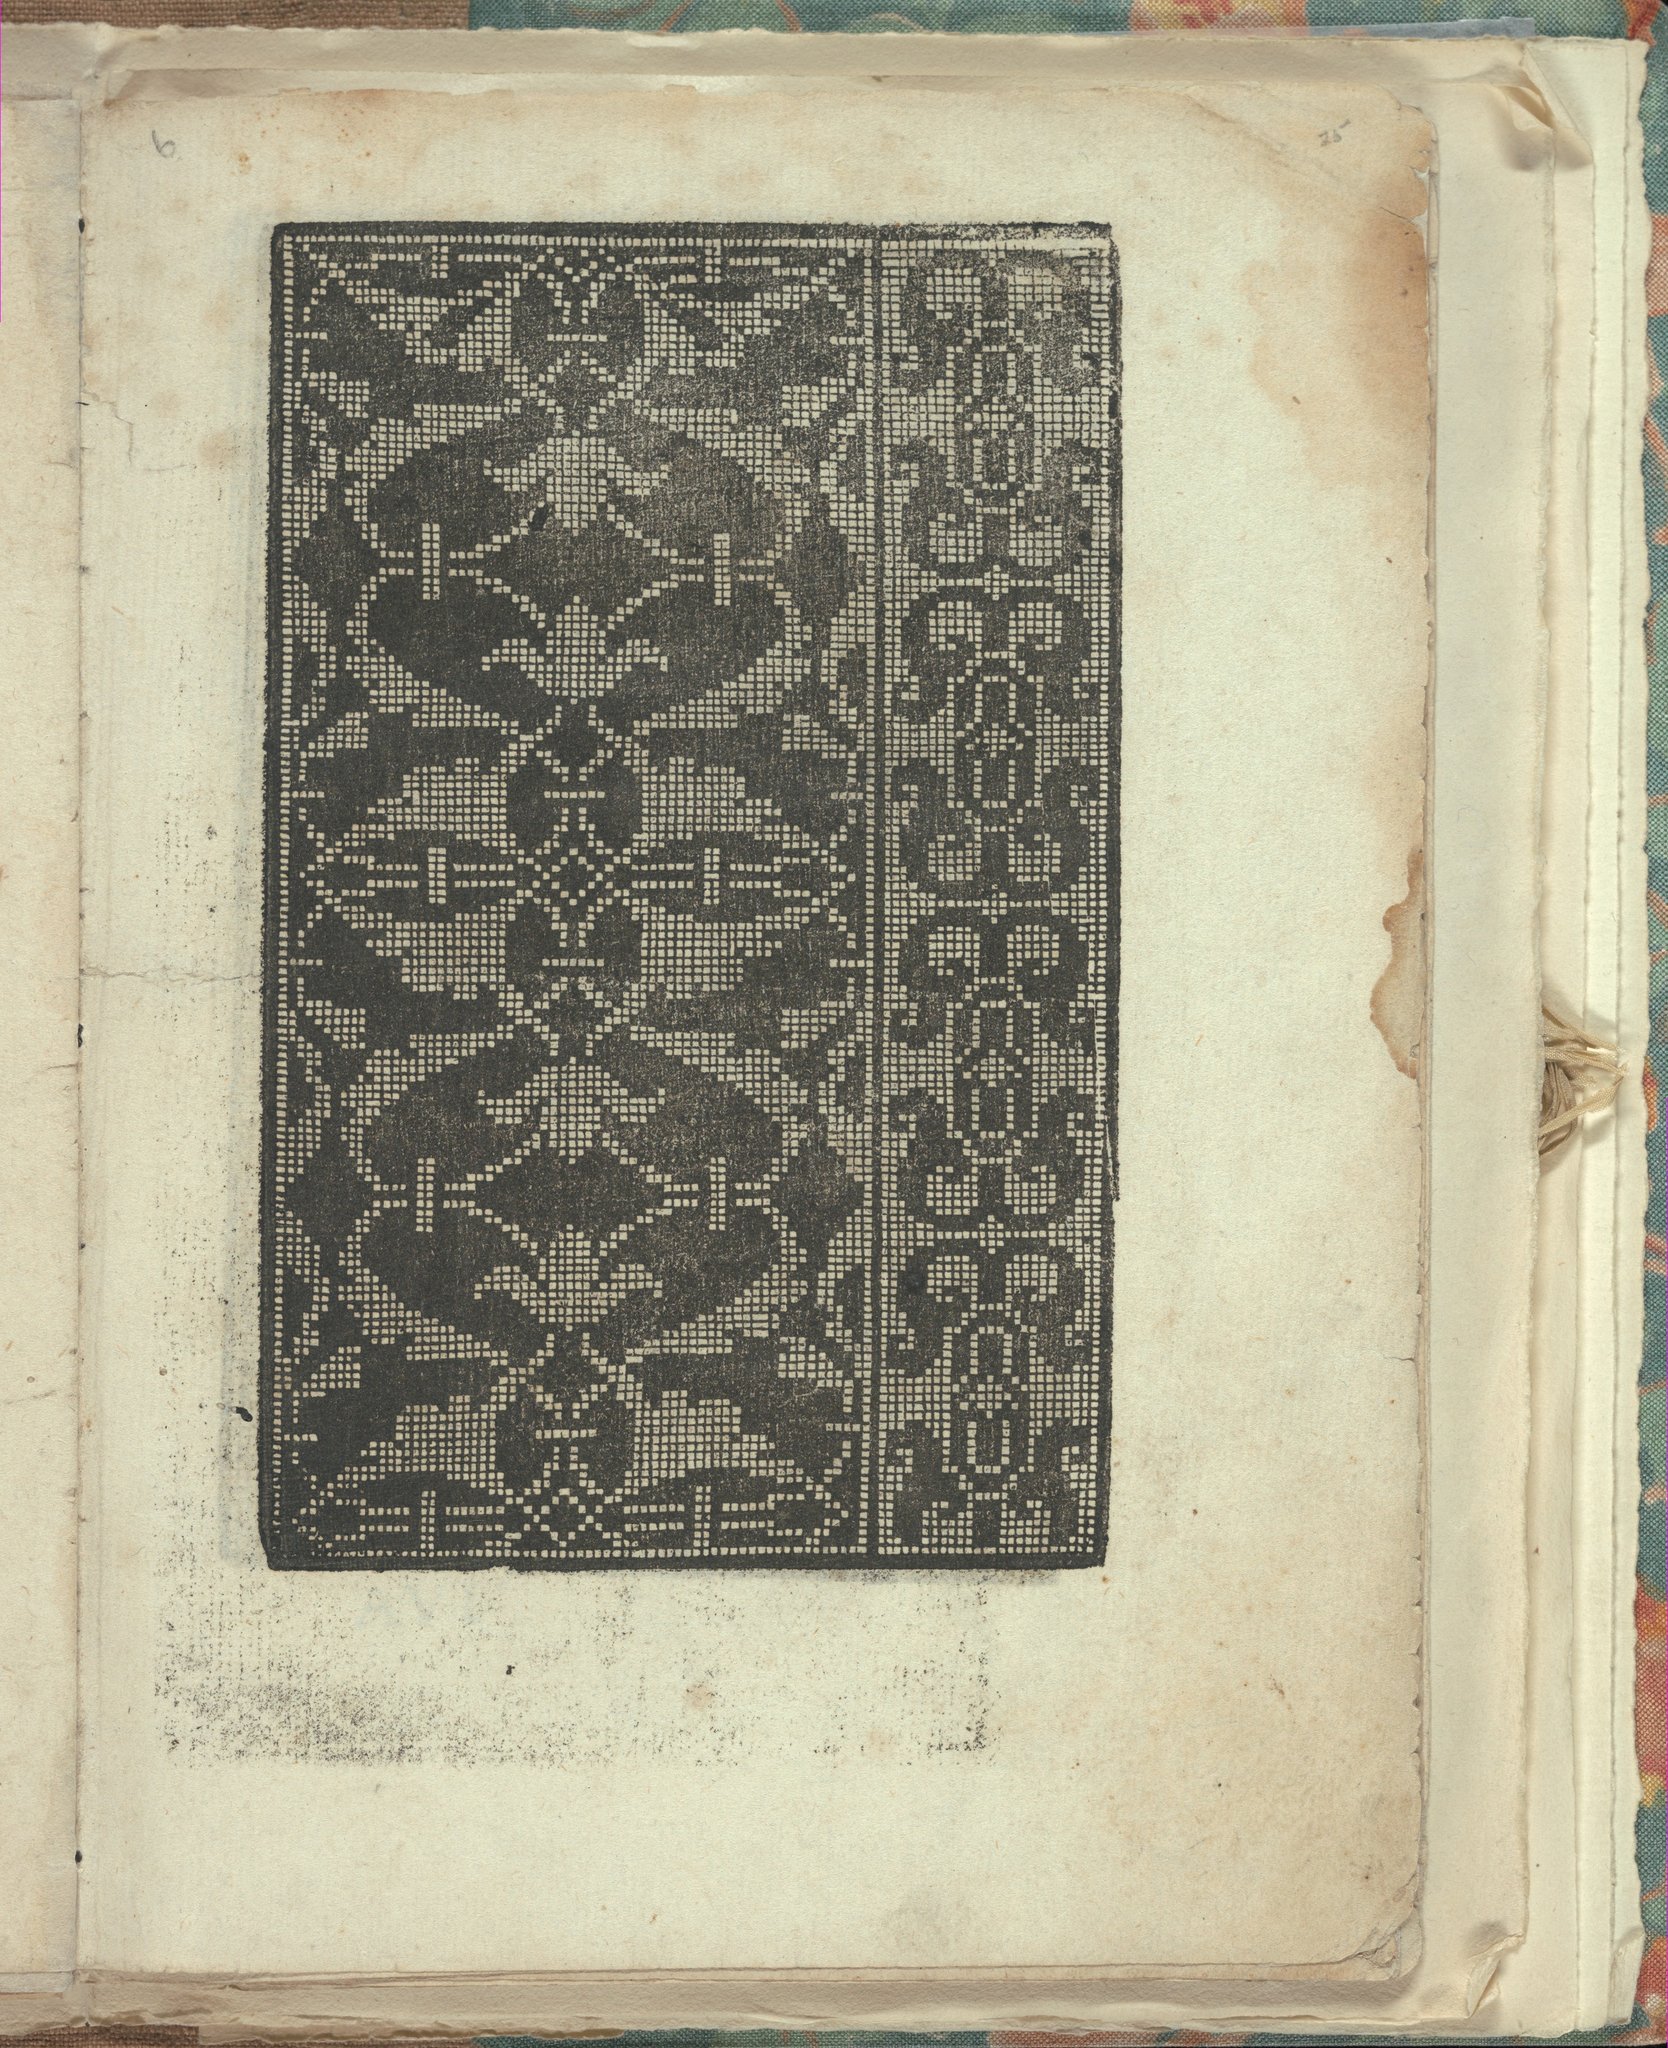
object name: book print ornament architecture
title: Opera Nova Universali intitulata Corona di racammi, page 25 (recto)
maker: giovanni andrea vavassore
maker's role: publisher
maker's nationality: italian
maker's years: 1530-1573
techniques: woodcut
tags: ornament